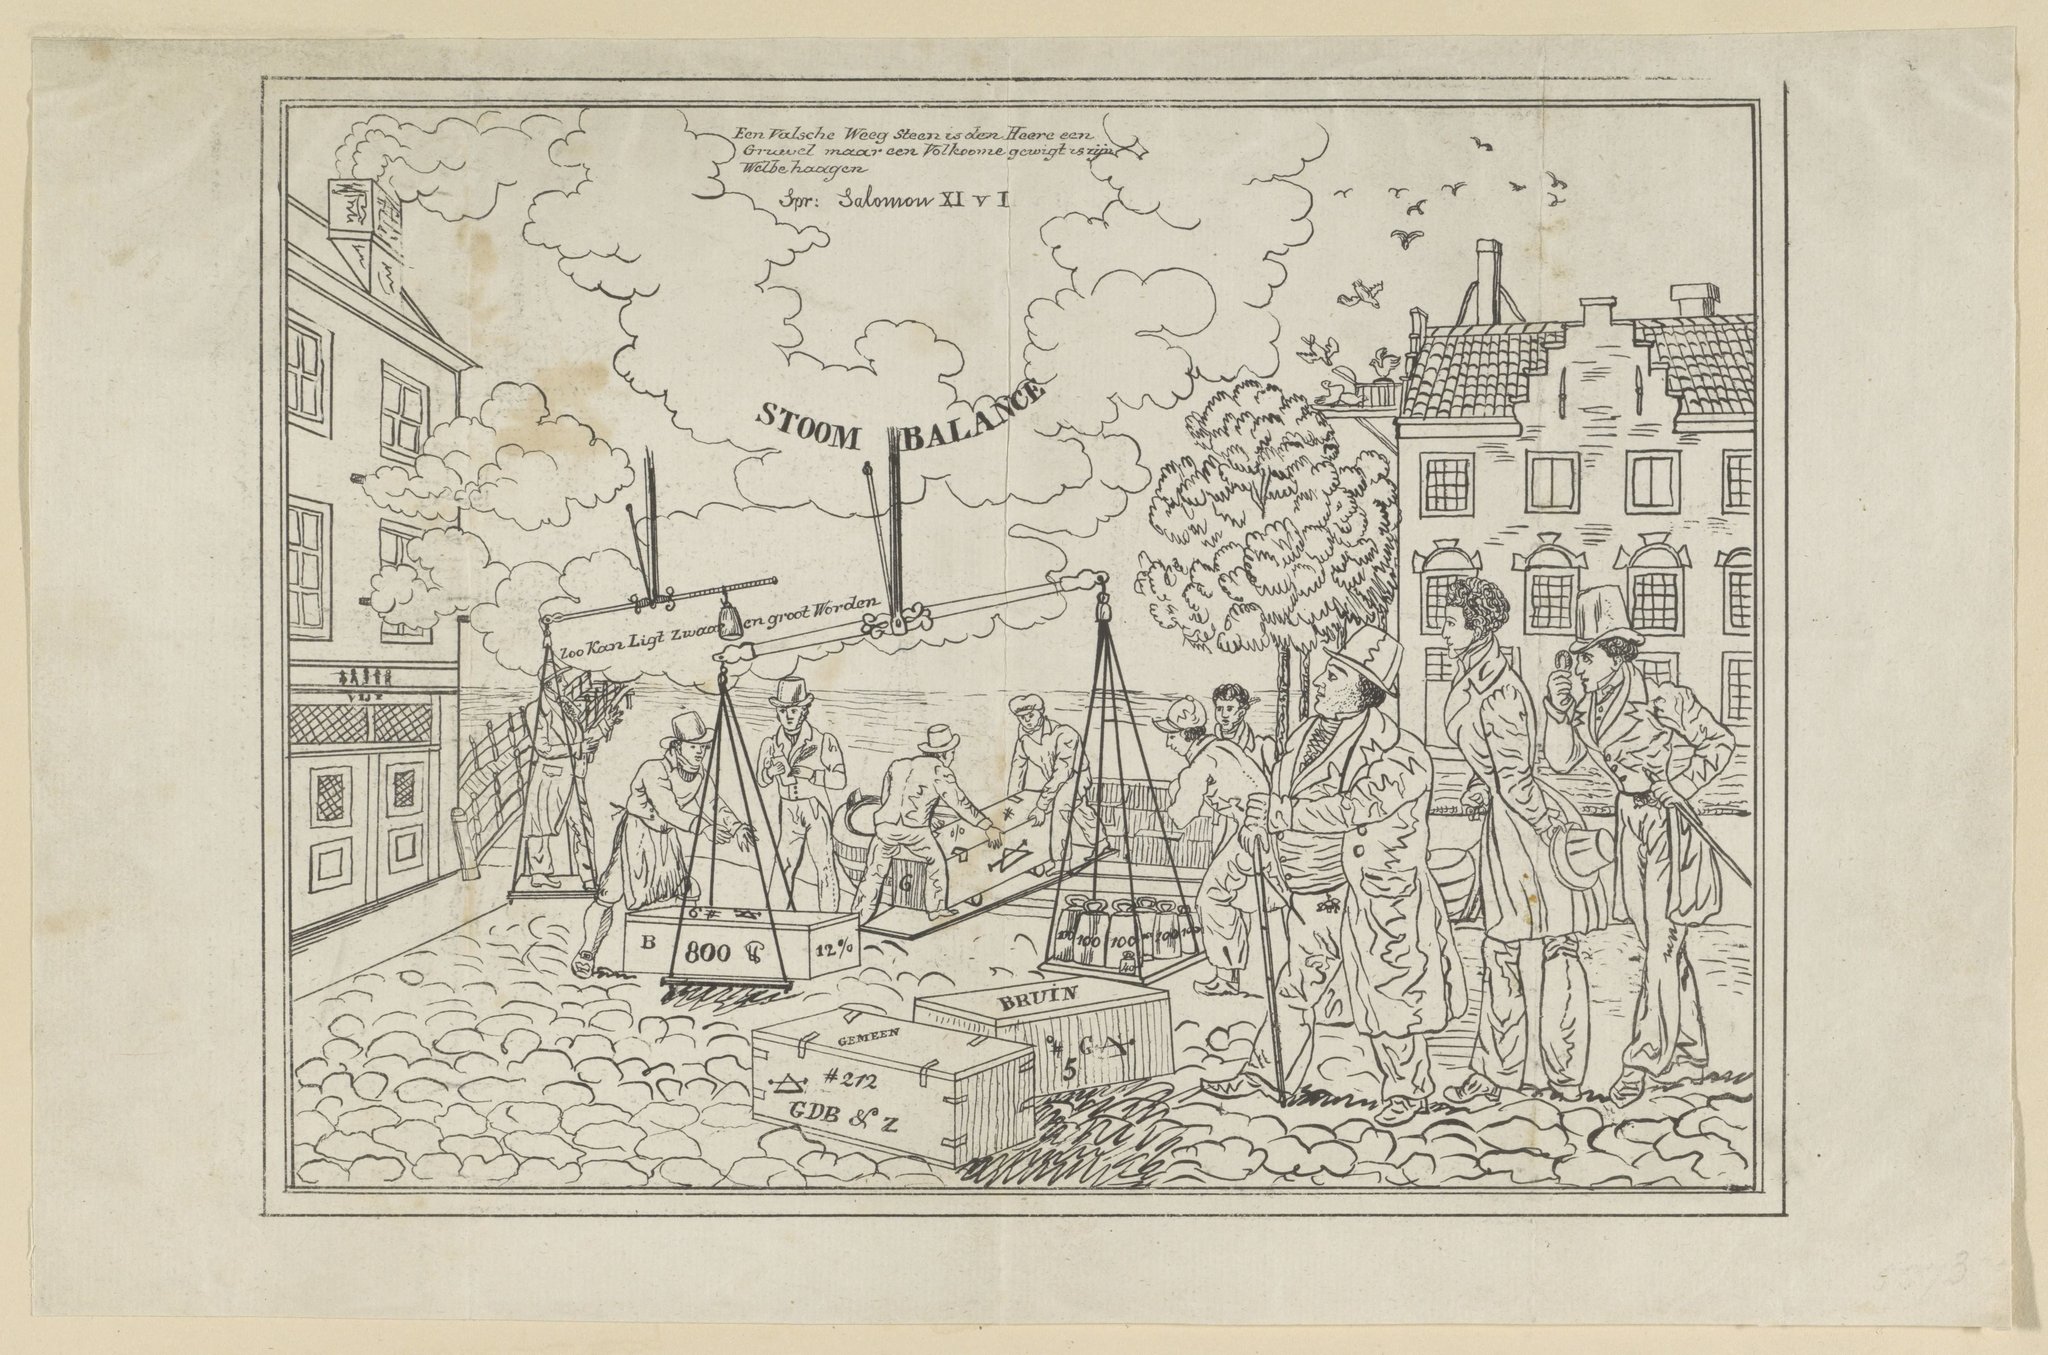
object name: print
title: Stoom Balance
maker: Anonymous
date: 1834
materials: paper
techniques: lithograph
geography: netherlands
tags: fraudulence, swindling, scales, industries ~ food, drink, stimulants, sugar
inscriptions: collector's mark: Lugt 2228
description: Spotprent op het bedrog met een valse weegschaal van de firma C. de Bruyn & Zonen, 1834. De firma bezat de eerste stoomsuikerraffinaderij aan de Lijnbaansgracht in Amsterdam. Op 8 januari 1834 werden zij betrapt op het gebruik van een balans waarvan een arm was verlengd. Centraal de valse balans hangend aan de stoomwolken die uit de fabriek 'De Vijf Gebroeders' komen en waarop kisten met suiker worden gewogen. Rechts C. de Bruyn met zijn twee zoons. In de wolken een bijbelcitaat.